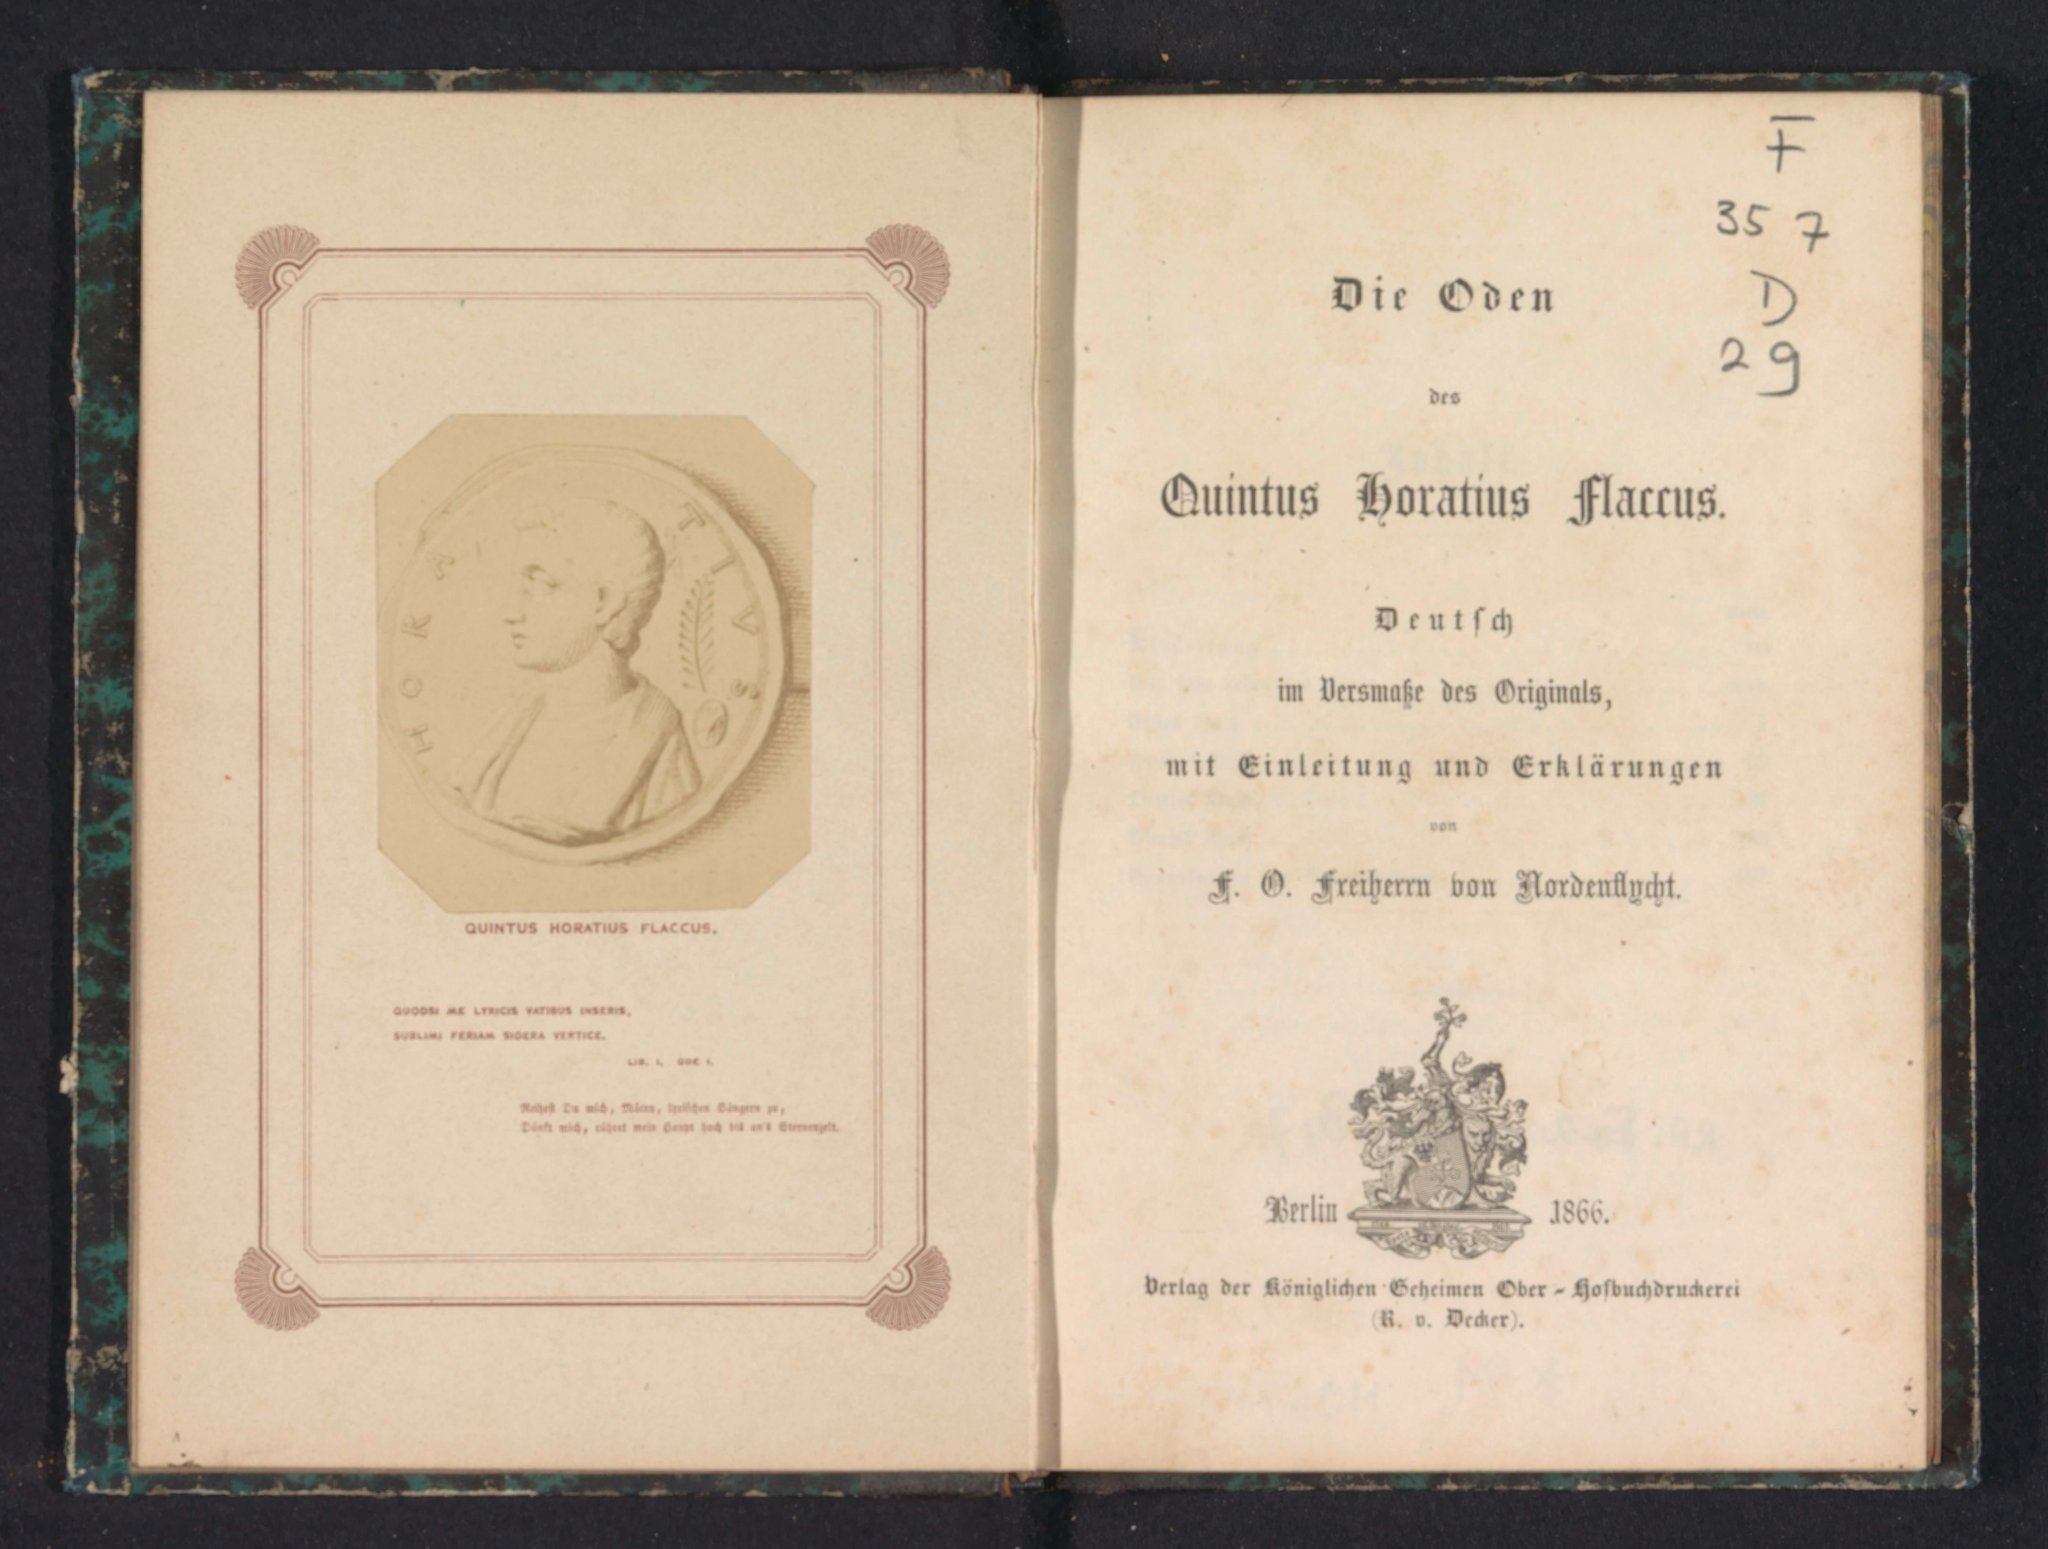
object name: photograph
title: Quintus Horatius Flaccus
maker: Anonymous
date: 1861-1866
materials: photographic support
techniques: albumen print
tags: (story of) horace, the poet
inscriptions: inscription: ‘Quodsi (...) Sternenzelt.’